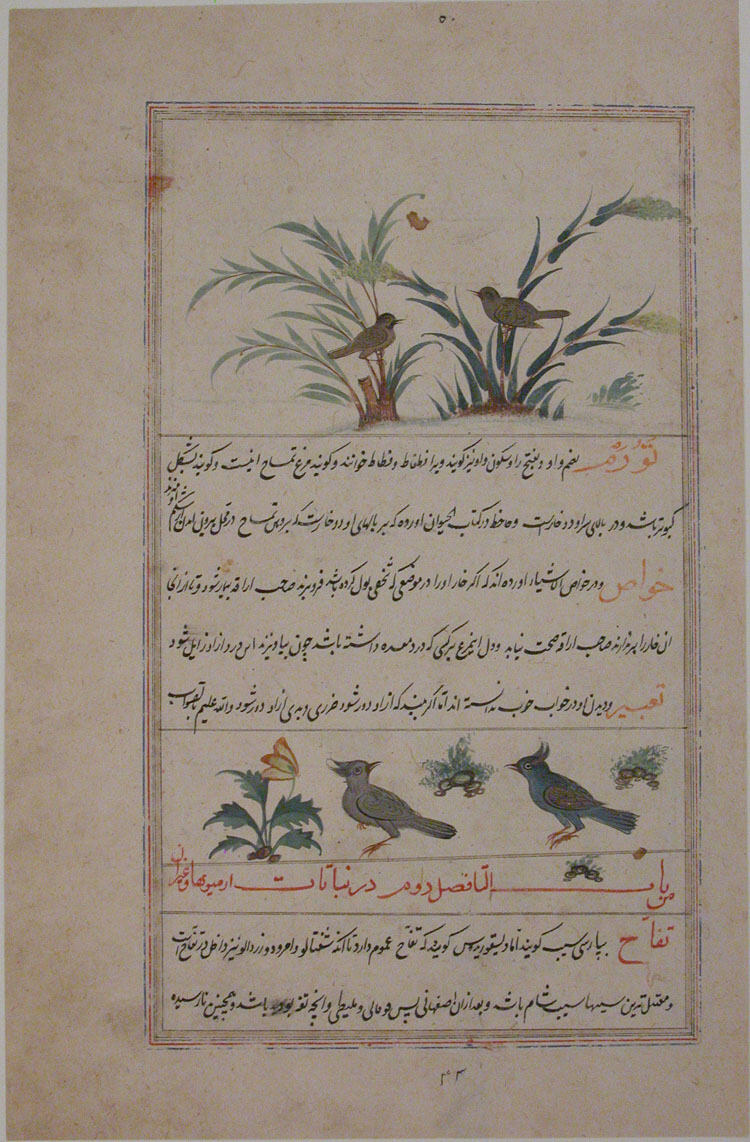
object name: folio from an illustrated manuscript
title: Folio from a Bestiary and Herbal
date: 1600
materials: gold, paper, watercolor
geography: iran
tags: birds,leaves